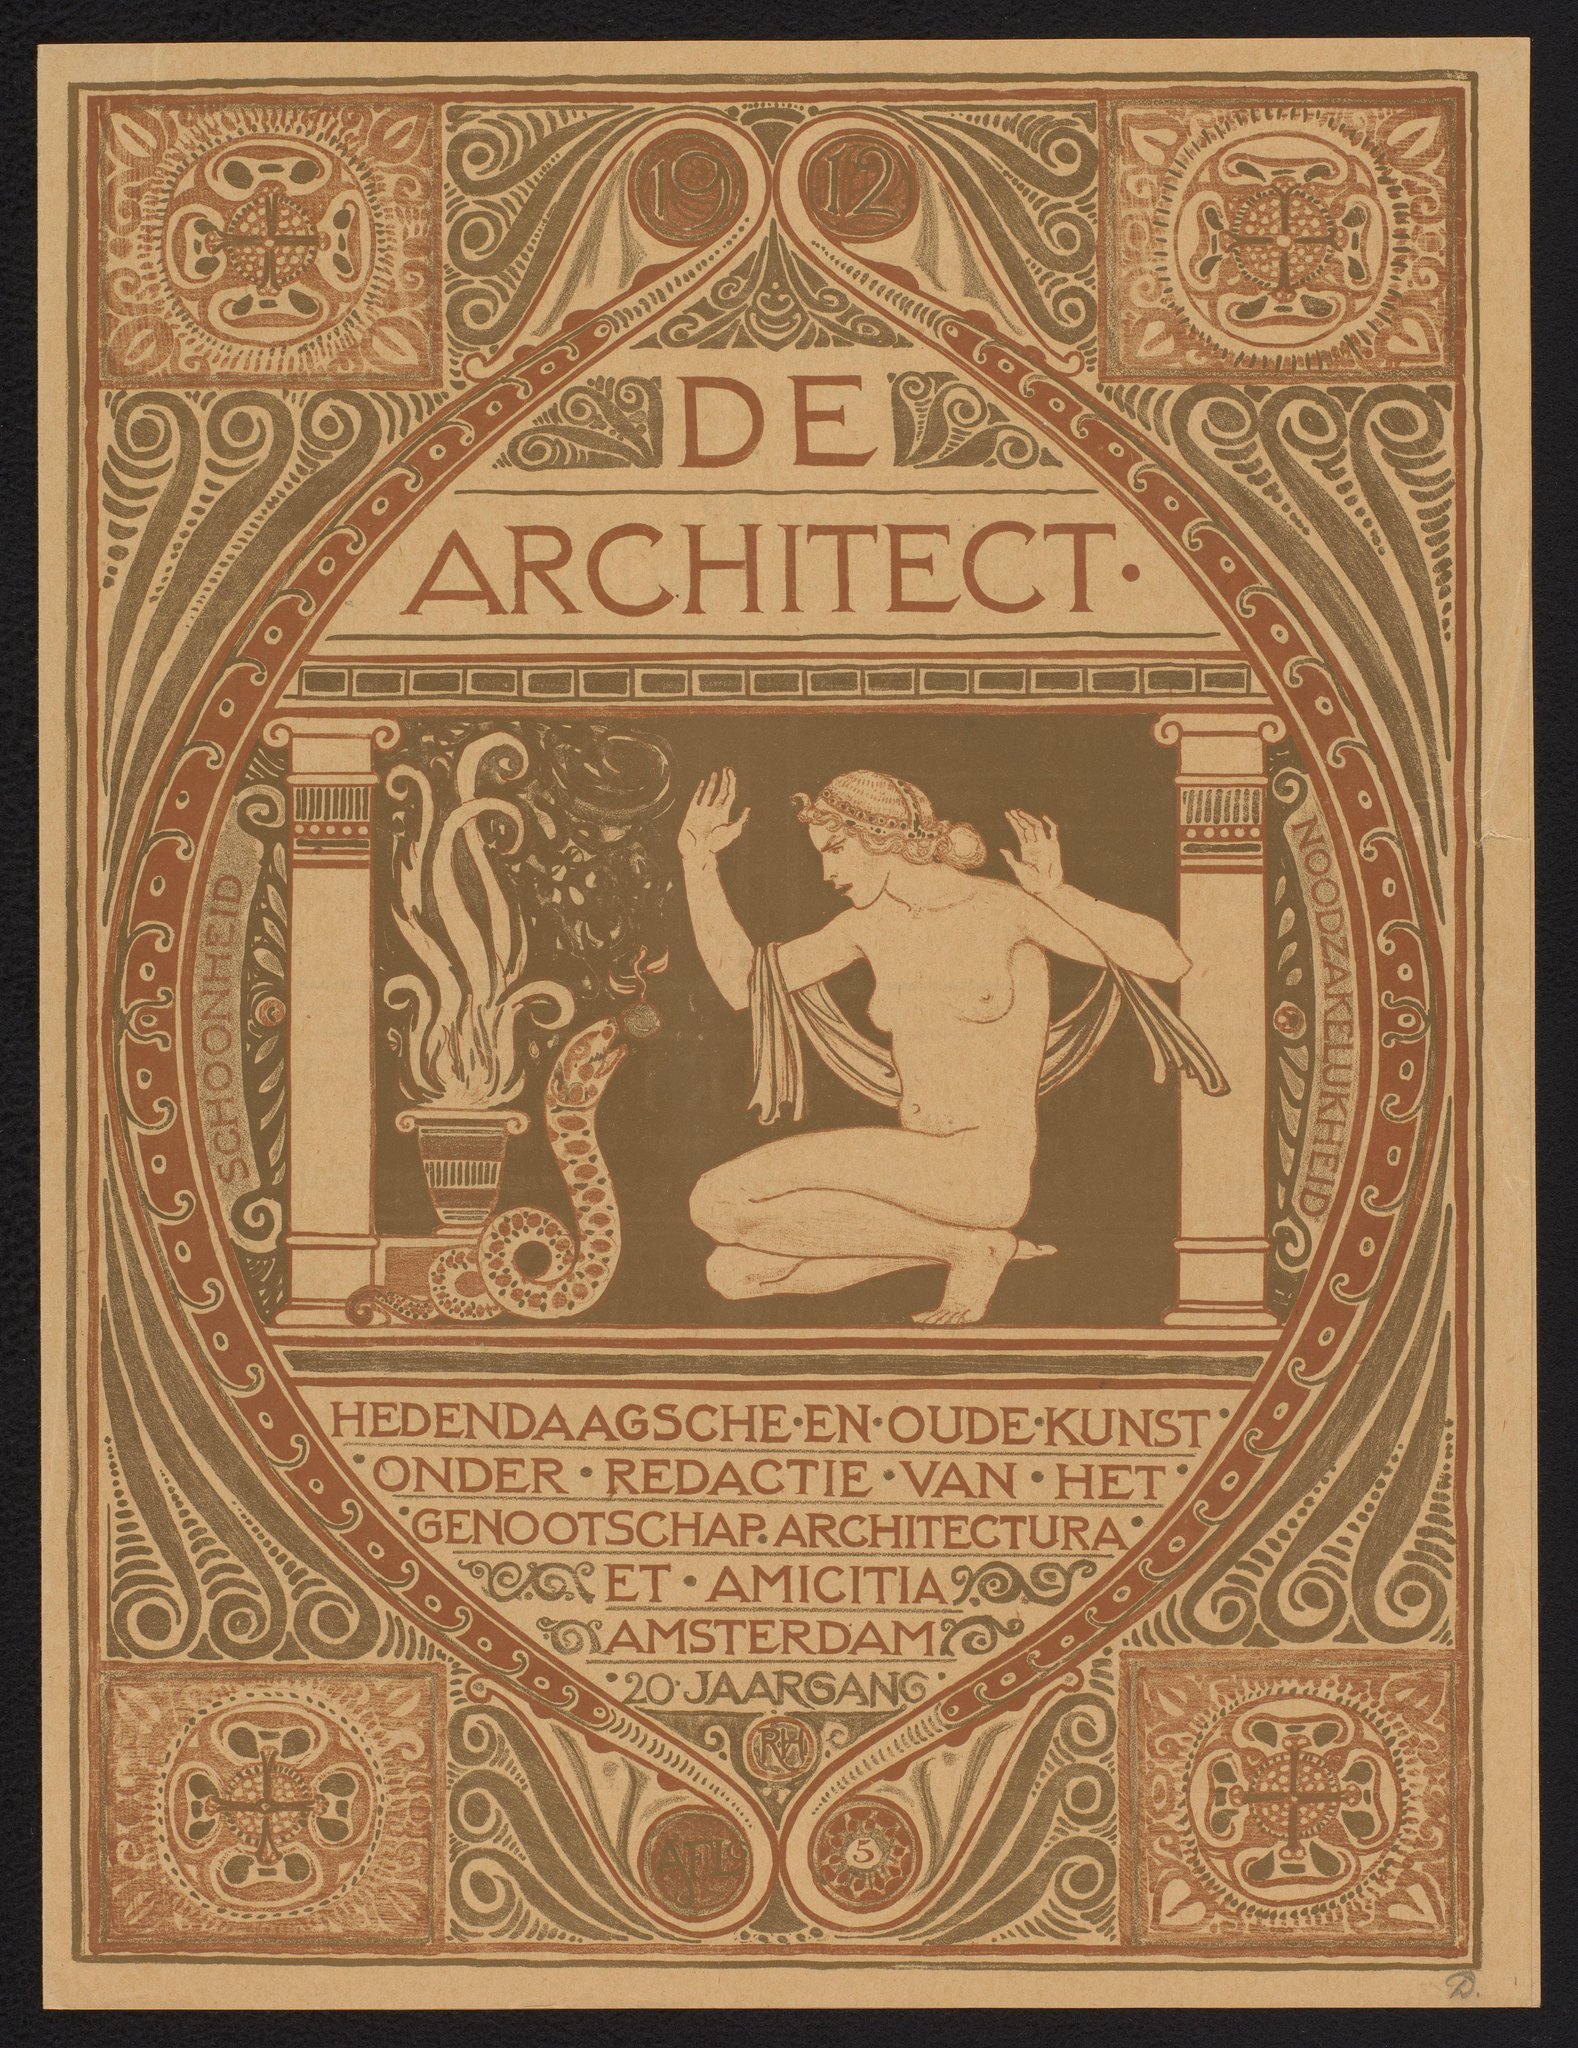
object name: print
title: Omslag voor: De architect, hedendaagsche en oude kunst, 1912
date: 1912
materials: paper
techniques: letterpress printing, lithograph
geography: amsterdam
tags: book-cover, binding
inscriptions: collector's mark: Lugt 2228, collector's mark: Lugt 2166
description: Prent gebruikt als omslag voor: De architect, hedendaagsche en oude kunst 20 (1912), aflevering 5.